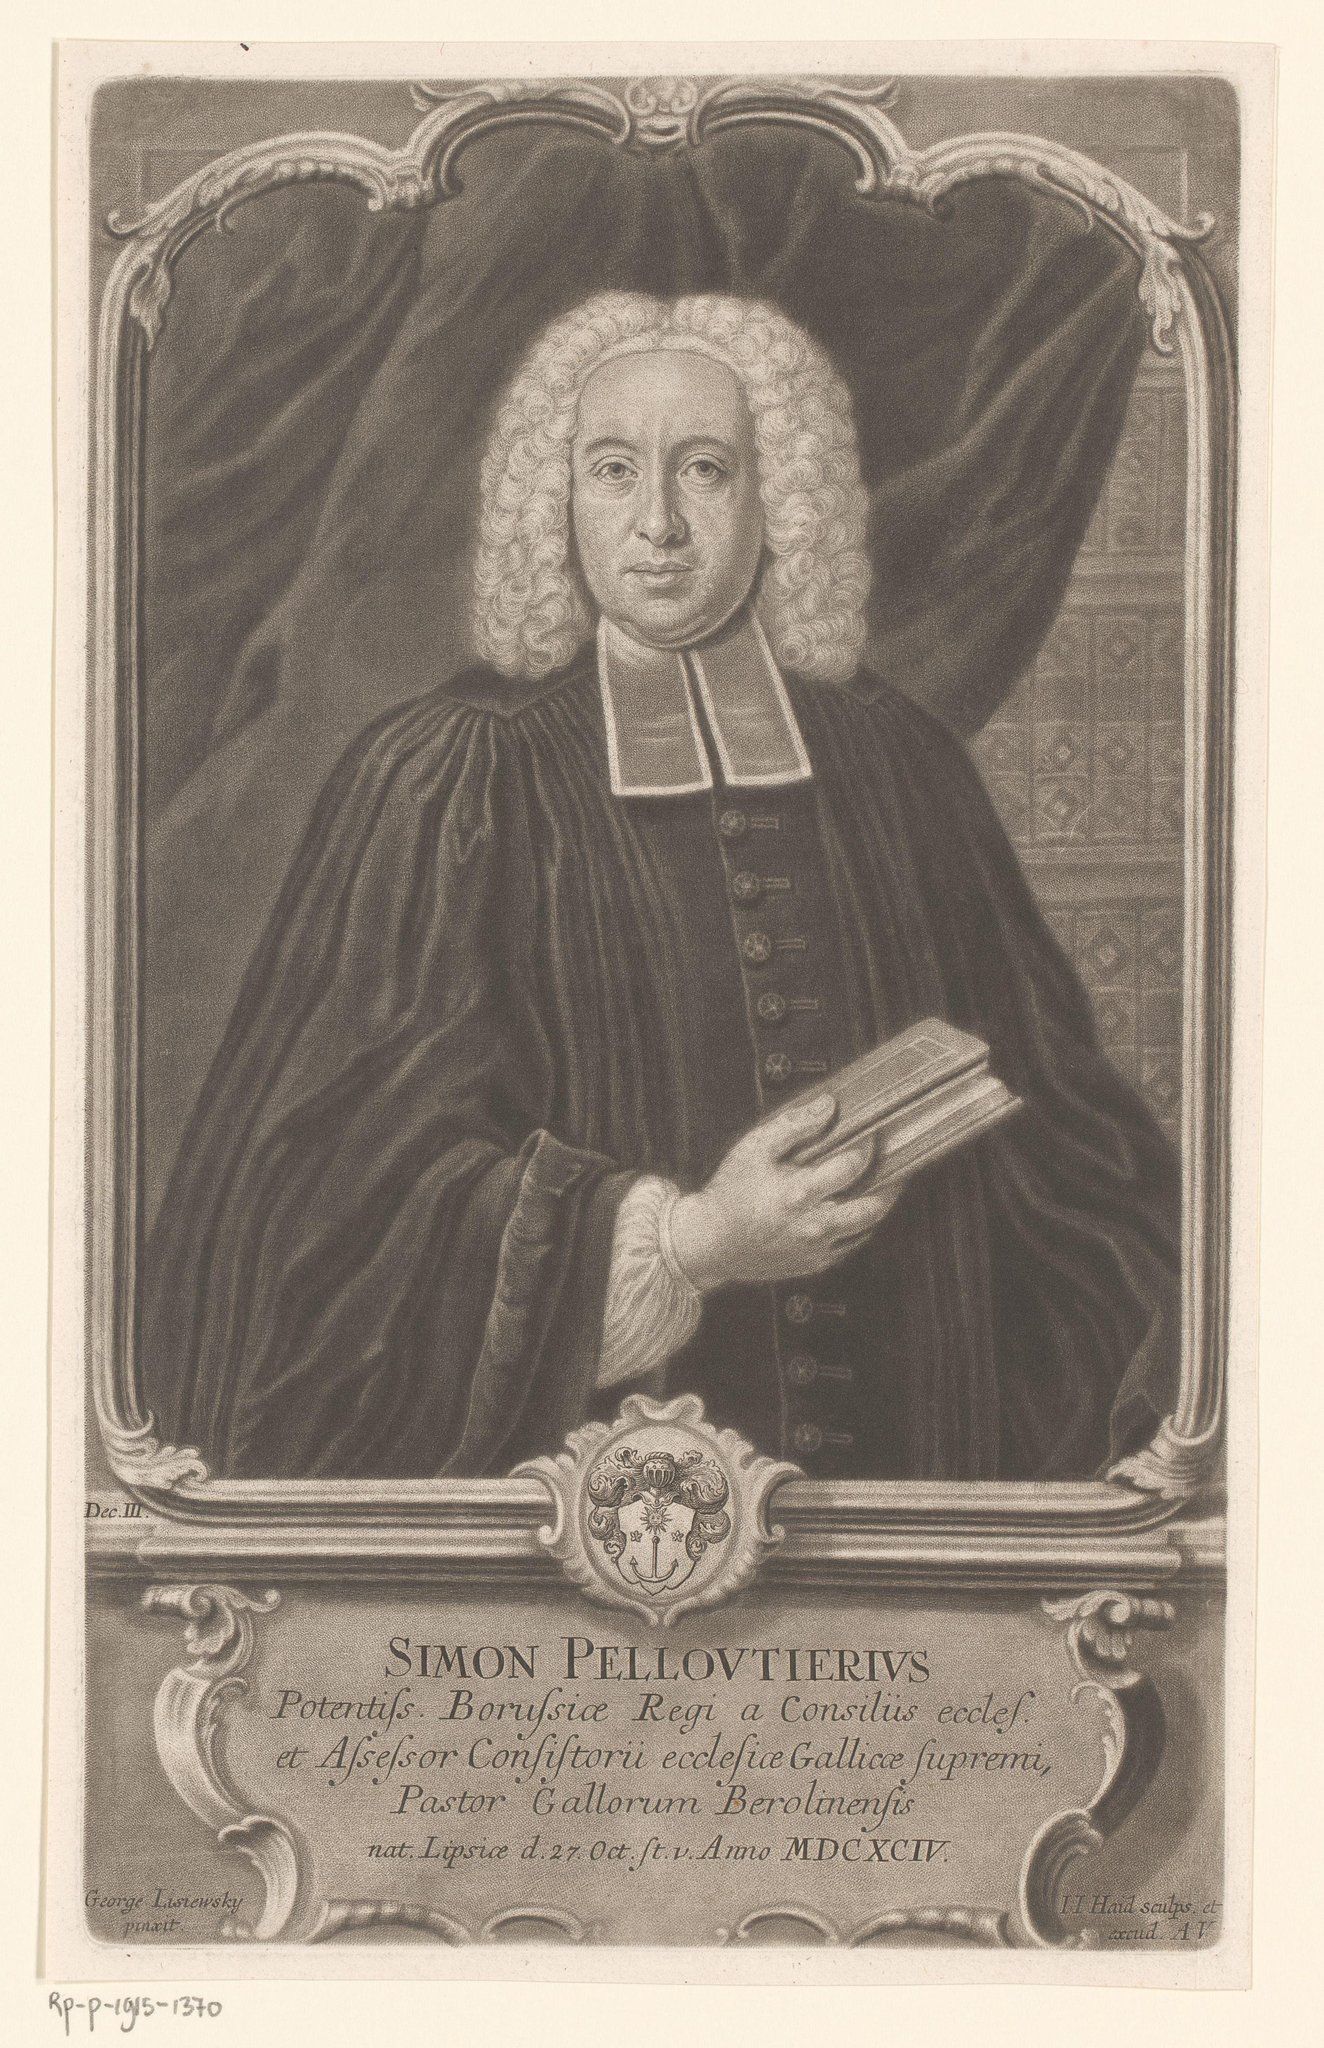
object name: print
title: Portret van Simon Pelloutier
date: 1744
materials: paper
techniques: etching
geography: augsburg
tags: bookshelves, historical persons, armorial bearing, heraldry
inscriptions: collector's mark: Lugt 2228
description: Prent gebruikt voor: Brucker, Jacob. Bildersal heutiges Tages lebender und durch Gelahrheit berühmter Schrifftsteller. Augsburg: Johann Jacob Haid, 1744.